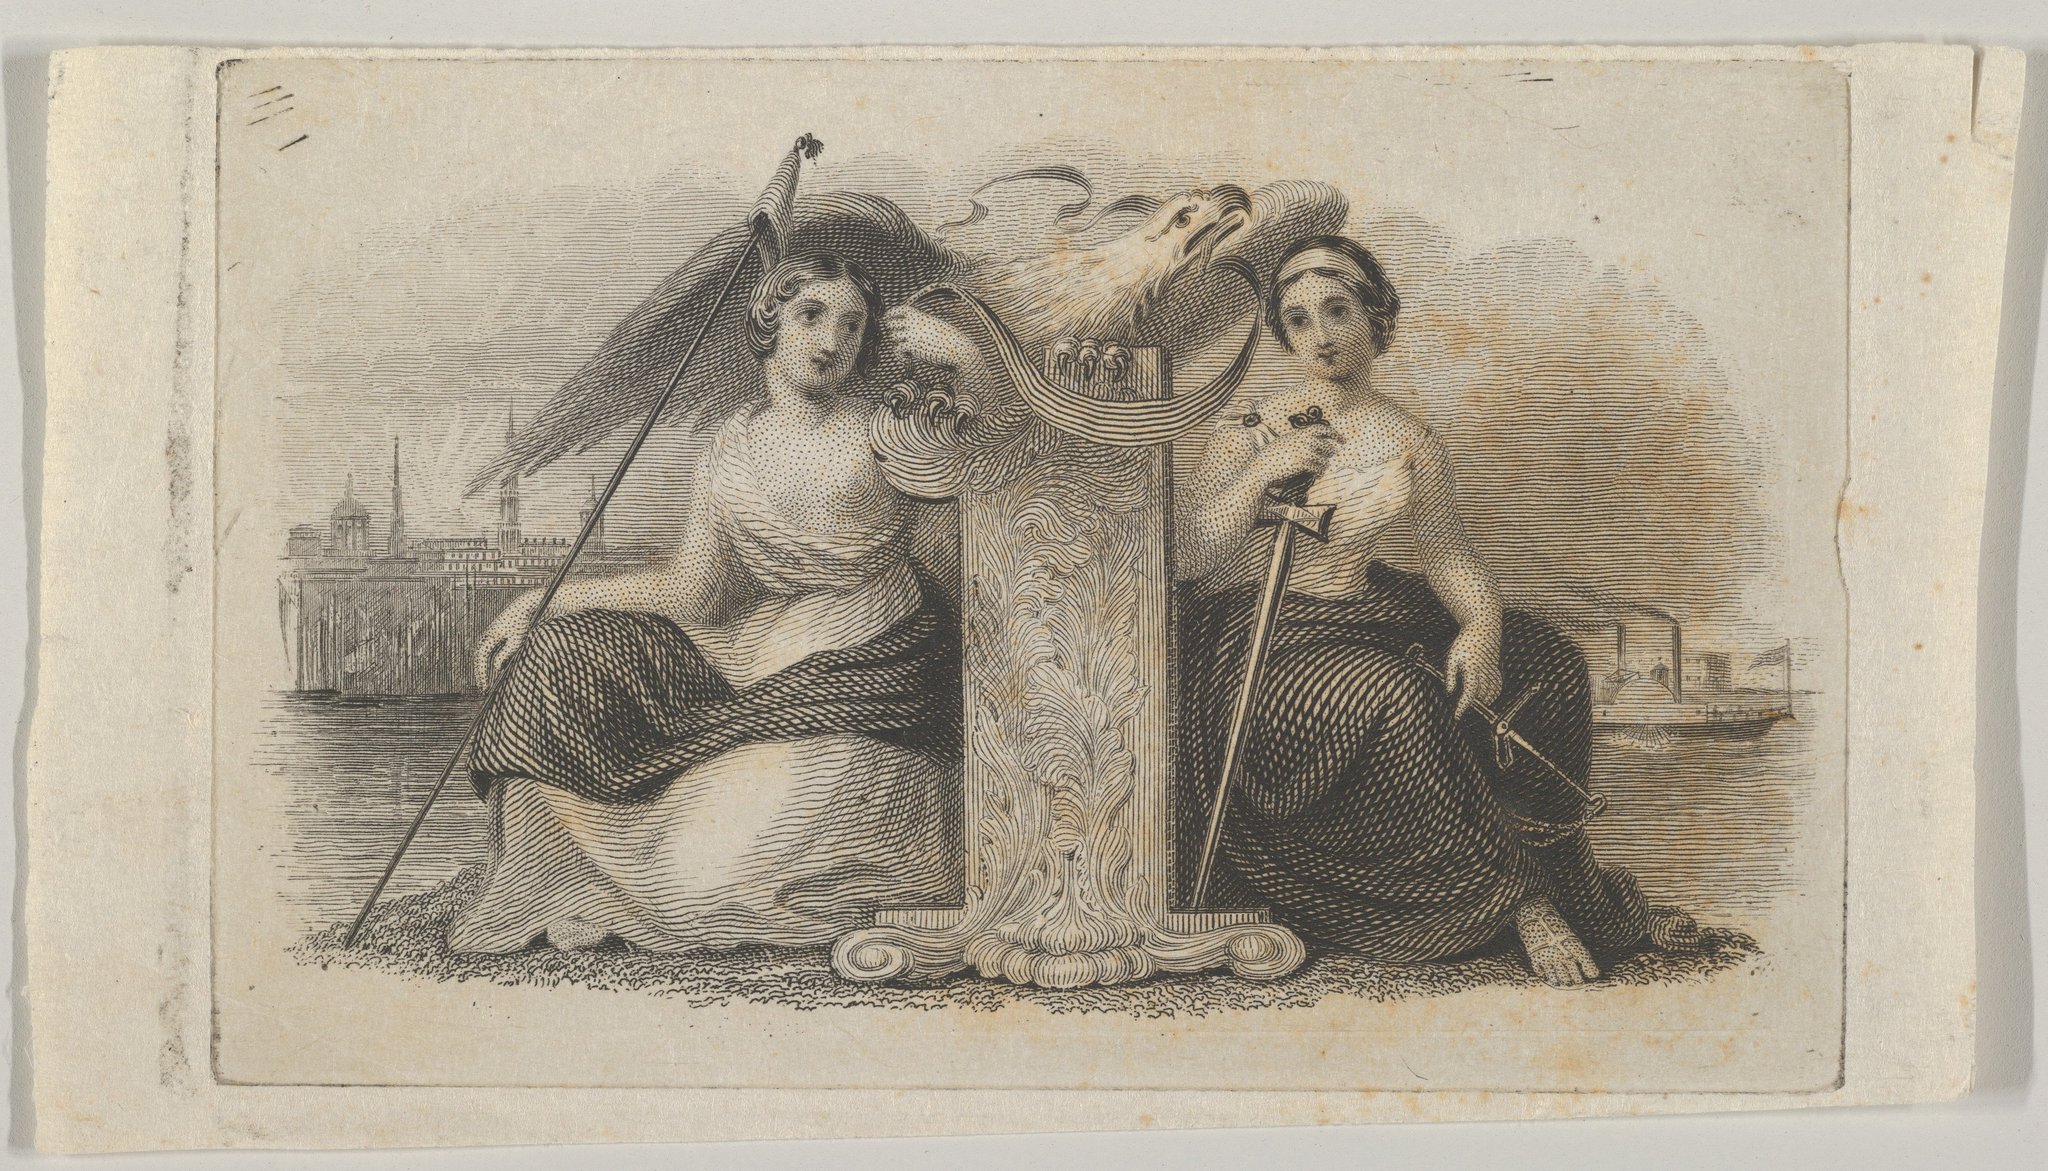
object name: print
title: Banknote vignette with female figures representing Liberty and Justice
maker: asher brown durand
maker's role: artist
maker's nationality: american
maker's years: 1796-1886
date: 1824-1837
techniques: engraving, etching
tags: eagles,women